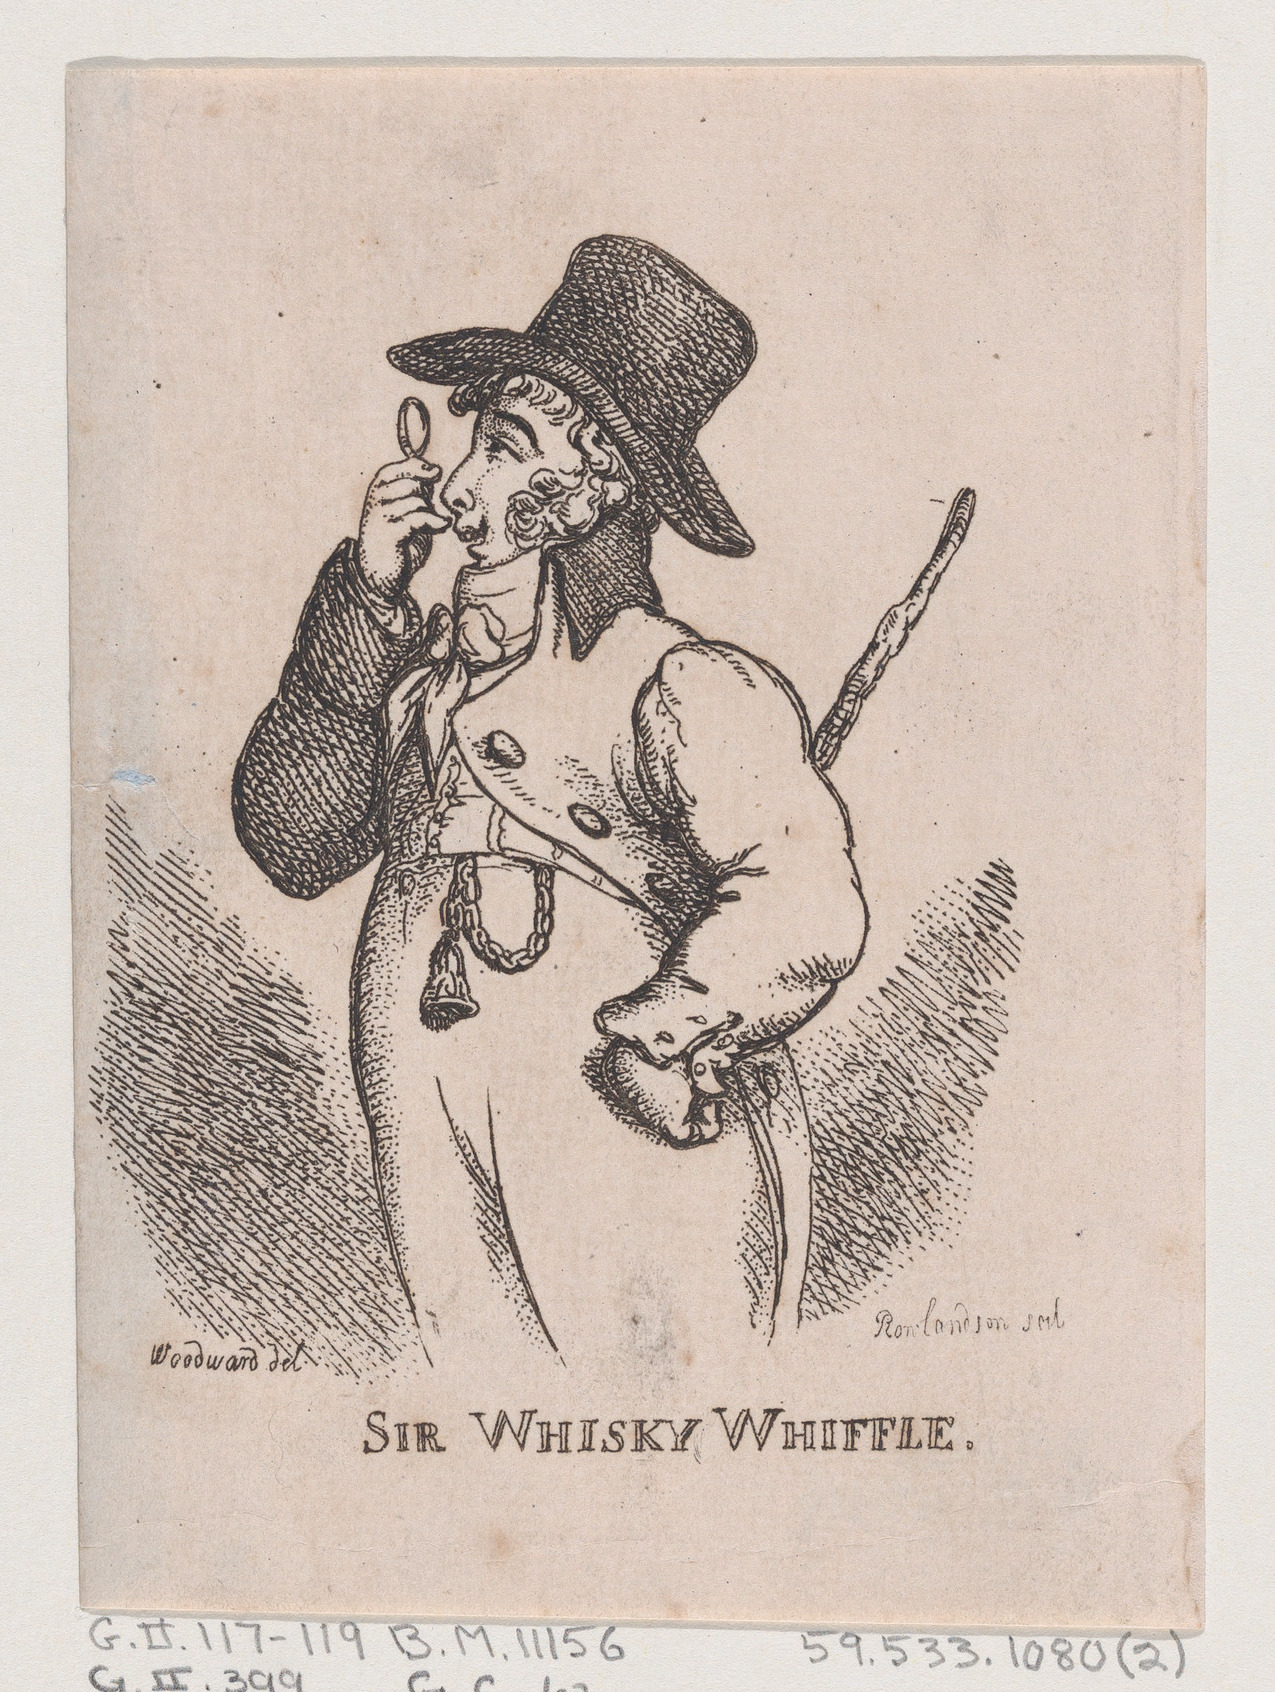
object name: print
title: Sir Whisky Whiffle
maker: thomas rowlandson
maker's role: artist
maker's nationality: british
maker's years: 1757-1827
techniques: etching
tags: men,profiles